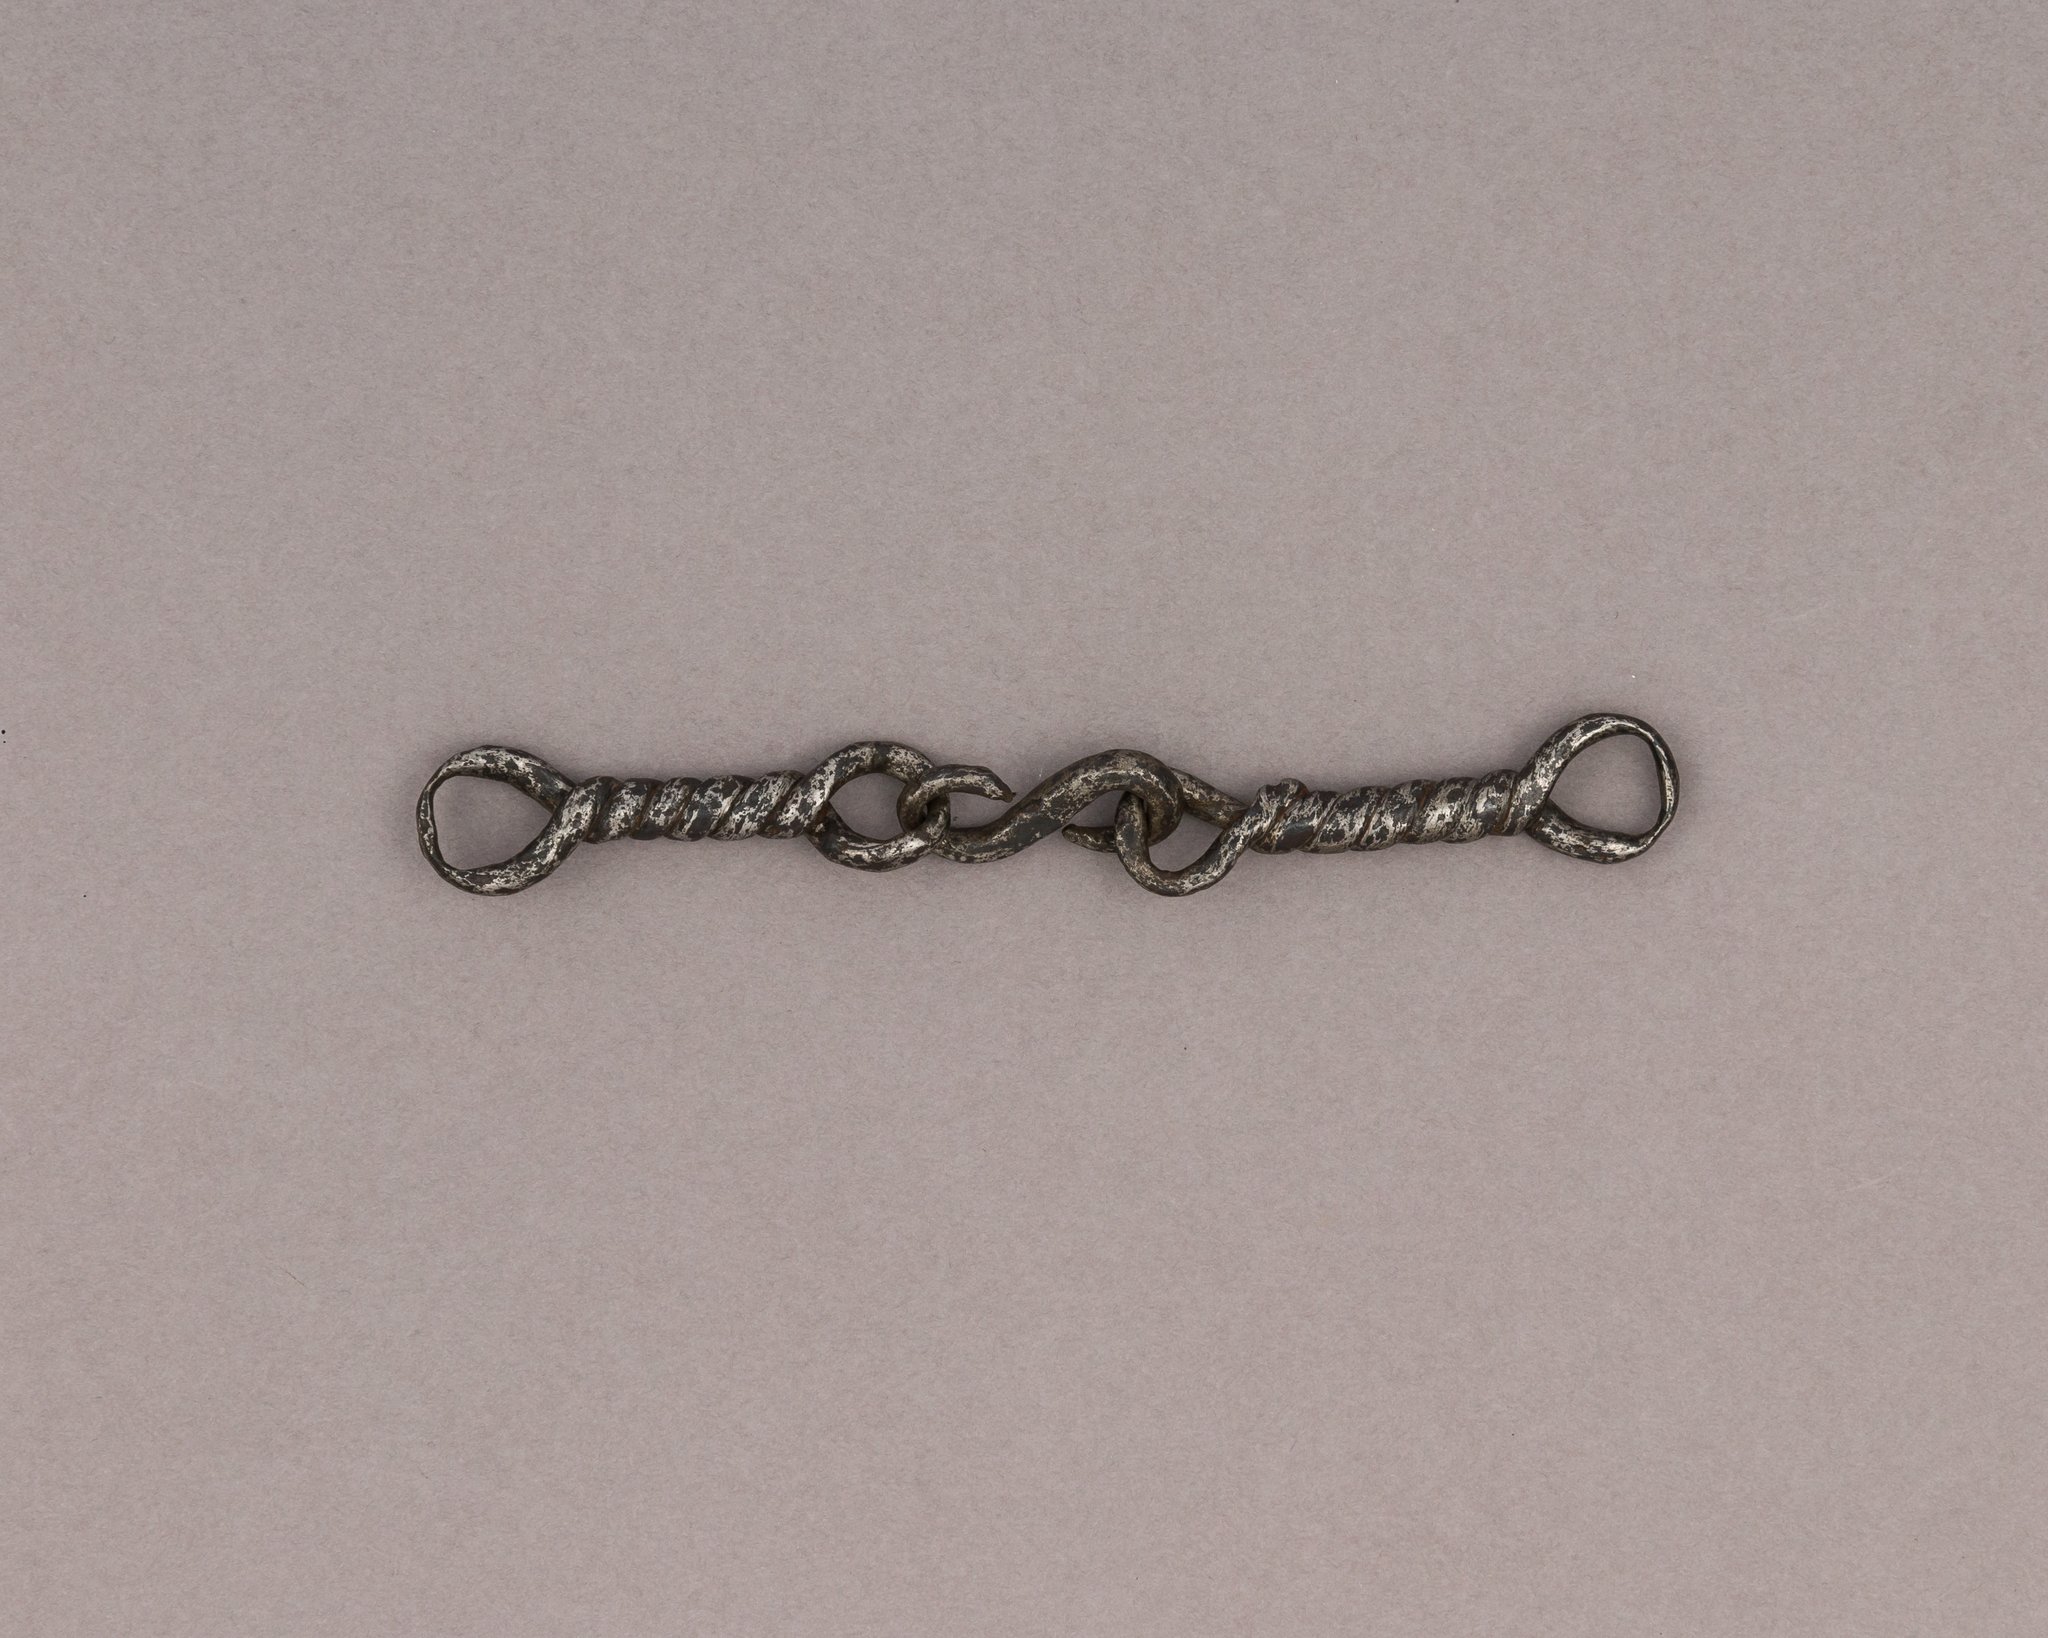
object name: bit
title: Snaffle Bit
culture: european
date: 1-400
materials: metal alloy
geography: czech republic